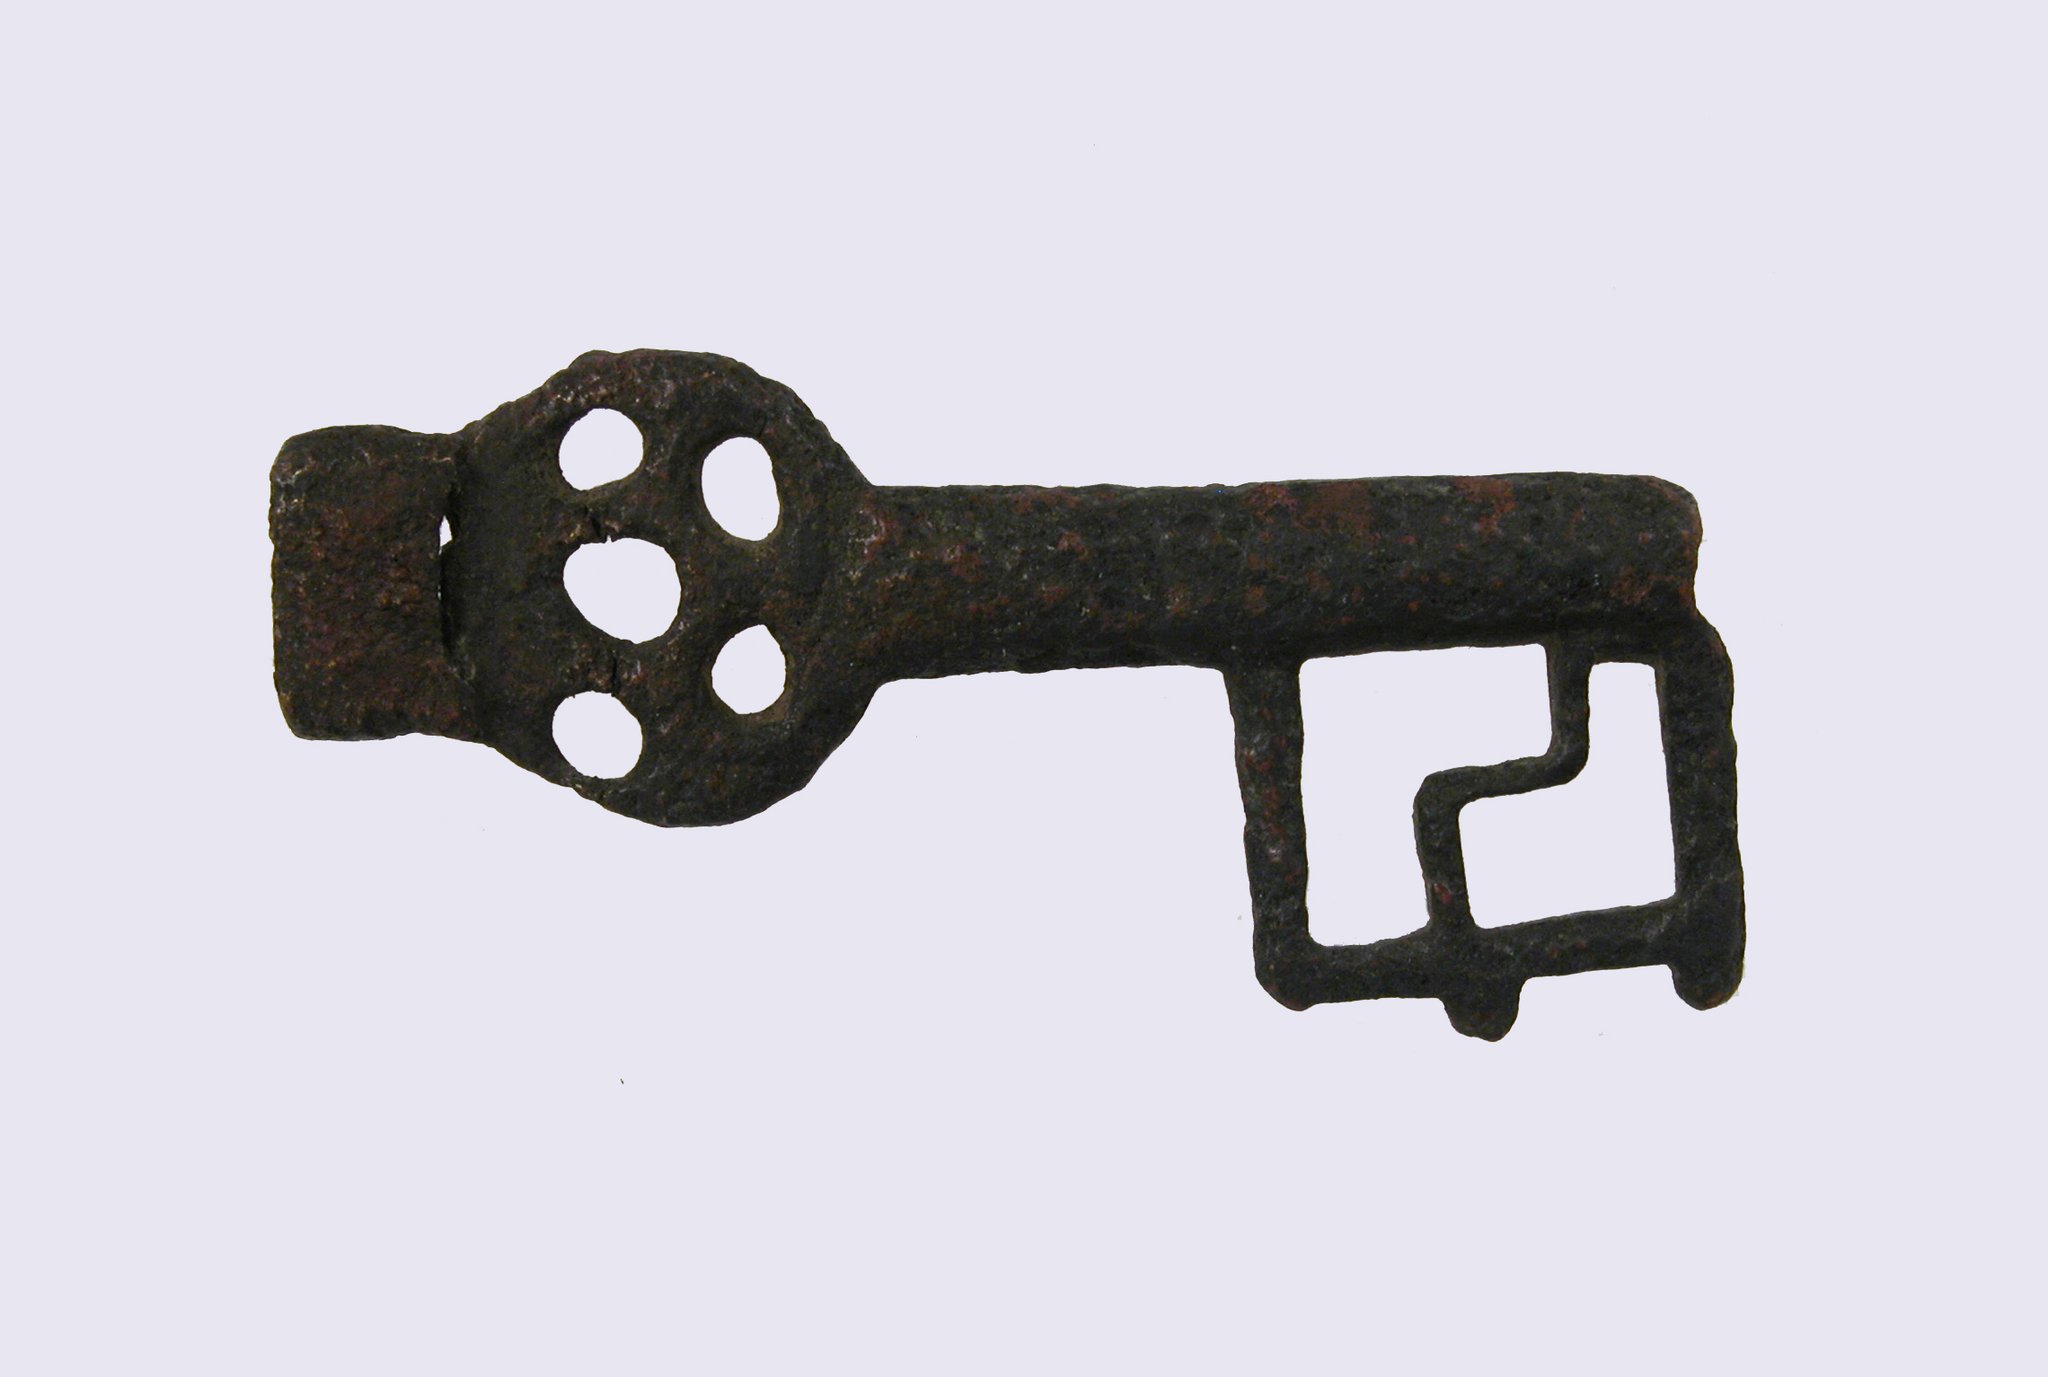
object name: key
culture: roman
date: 1-700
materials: copper alloy